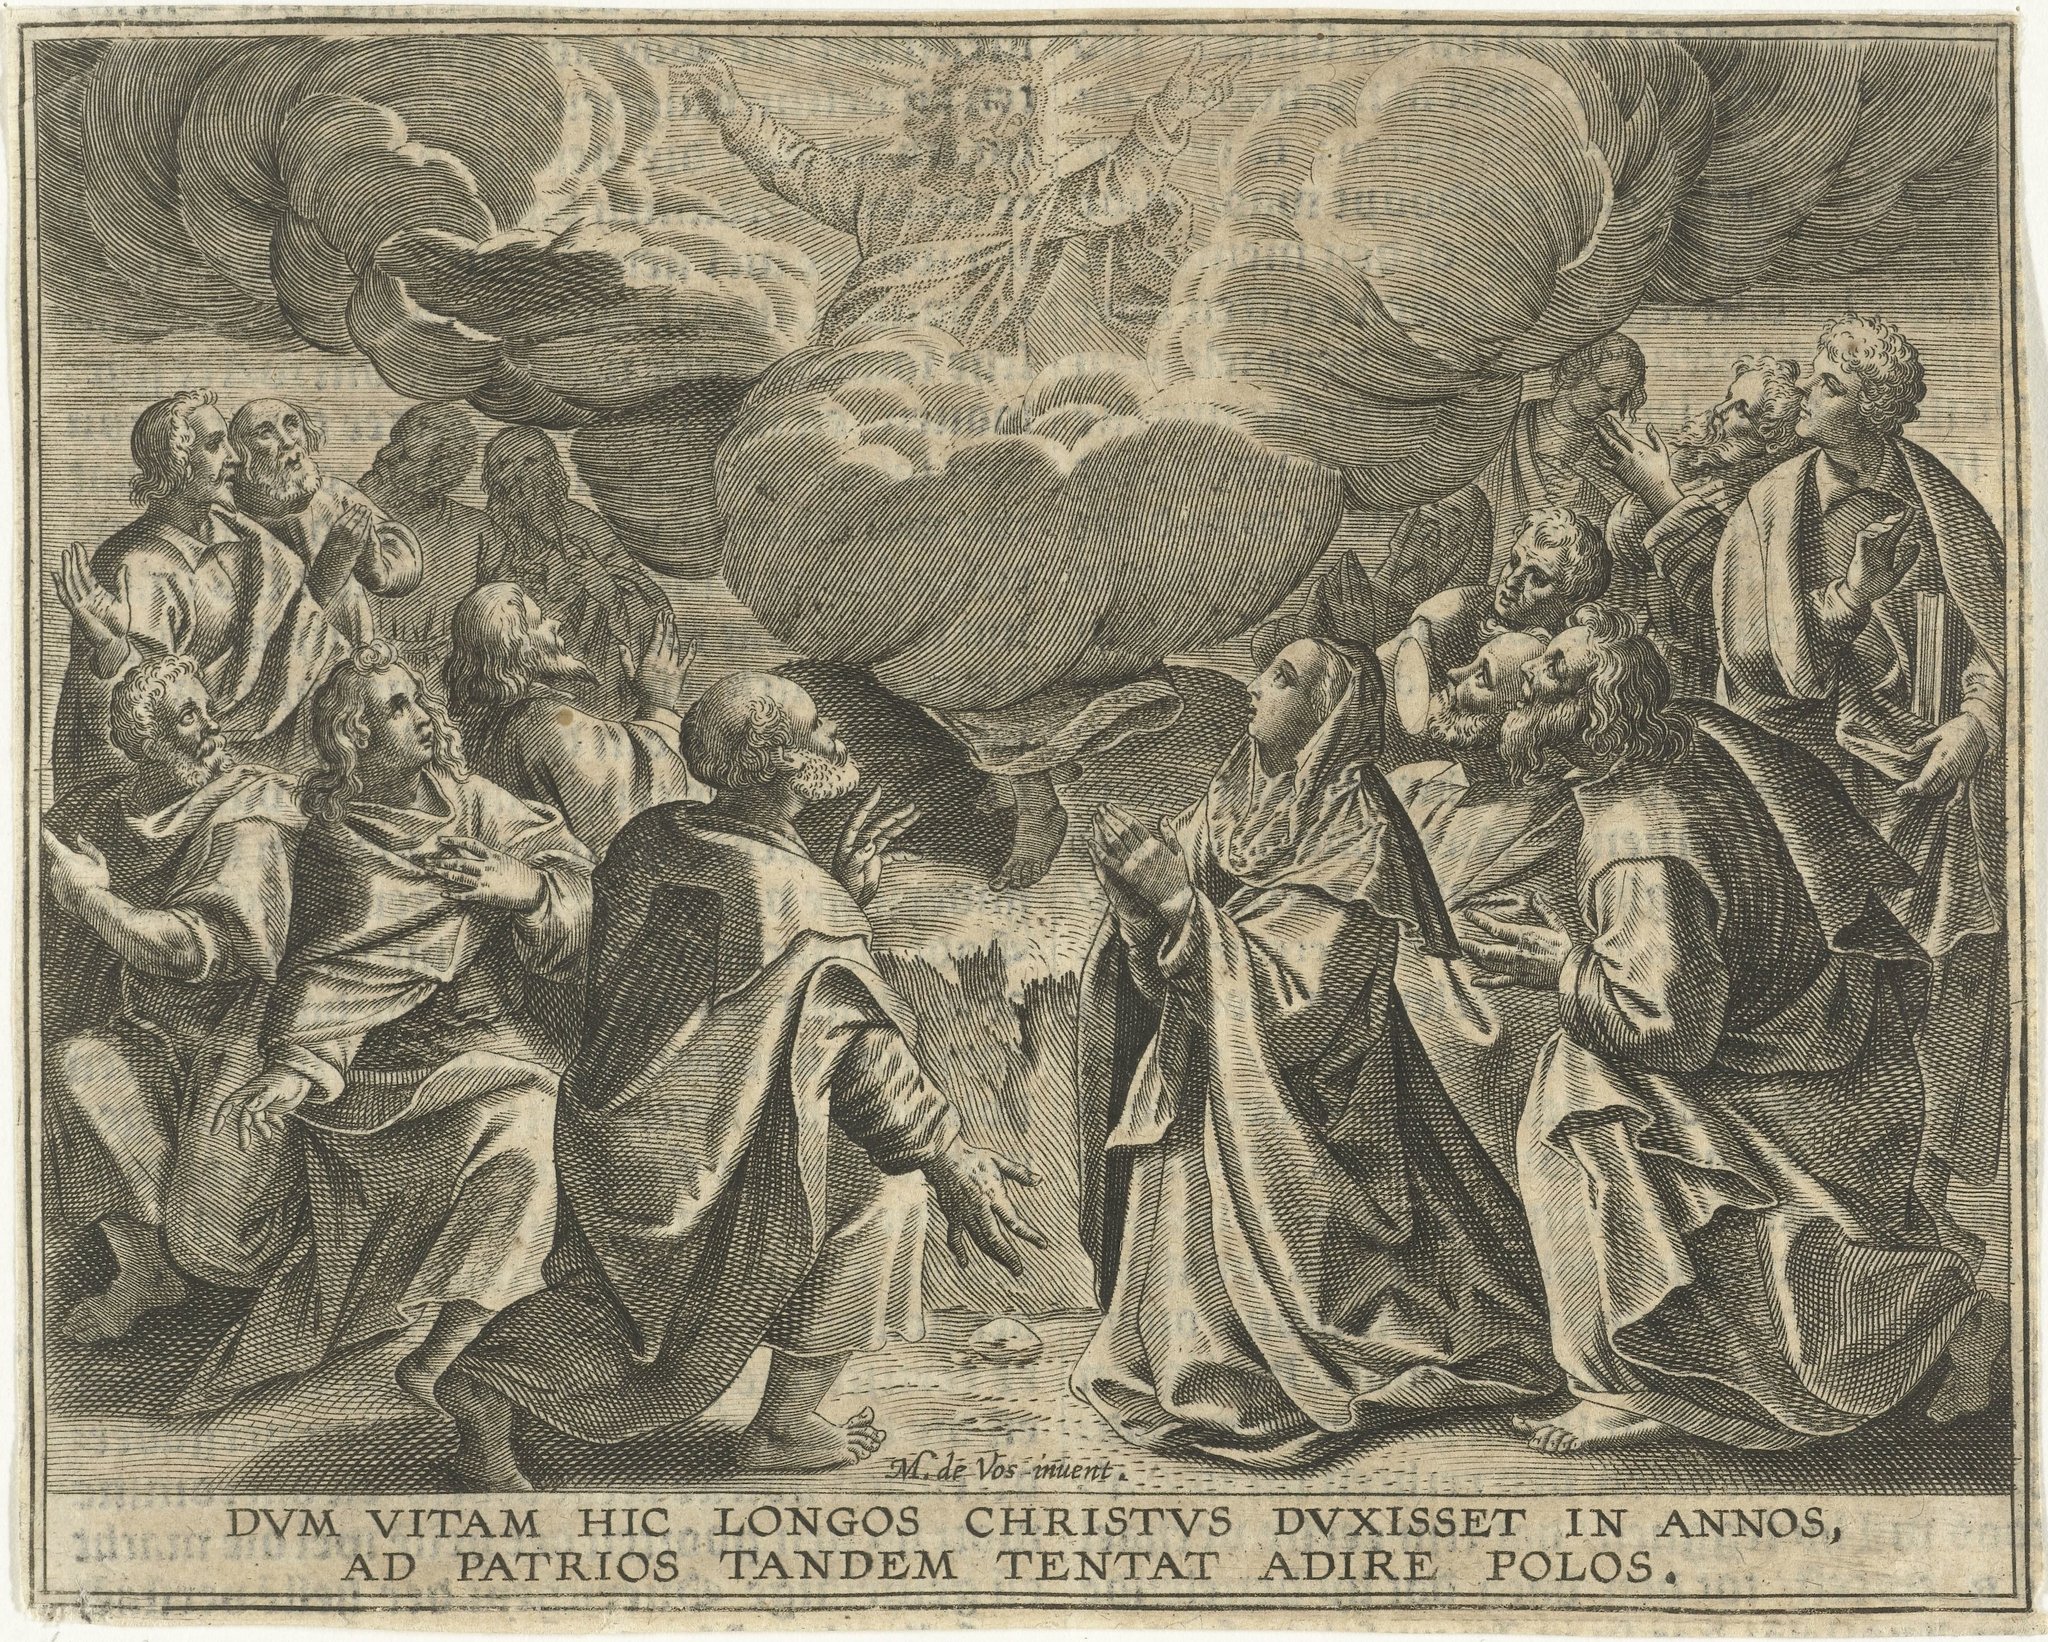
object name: book illustration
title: Hemelvaart van Christus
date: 1597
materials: paper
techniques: engraving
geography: antwerp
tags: the ascension (christ surrounded by radiant light or in a mandorla)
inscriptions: collector's mark: Lugt 2228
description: Christus wordt in een wolk naar de hemel gevoerd. Rondom hem zijn leerlingen en zijn moeder, de maagd Maria. De prent heeft een Latijns onderschrift.